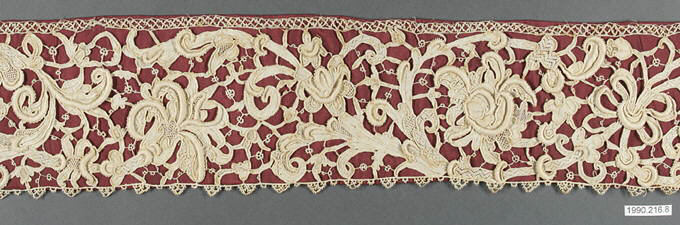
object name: edging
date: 1701-1800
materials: lace, silk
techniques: lace, gros point, lining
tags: flowers